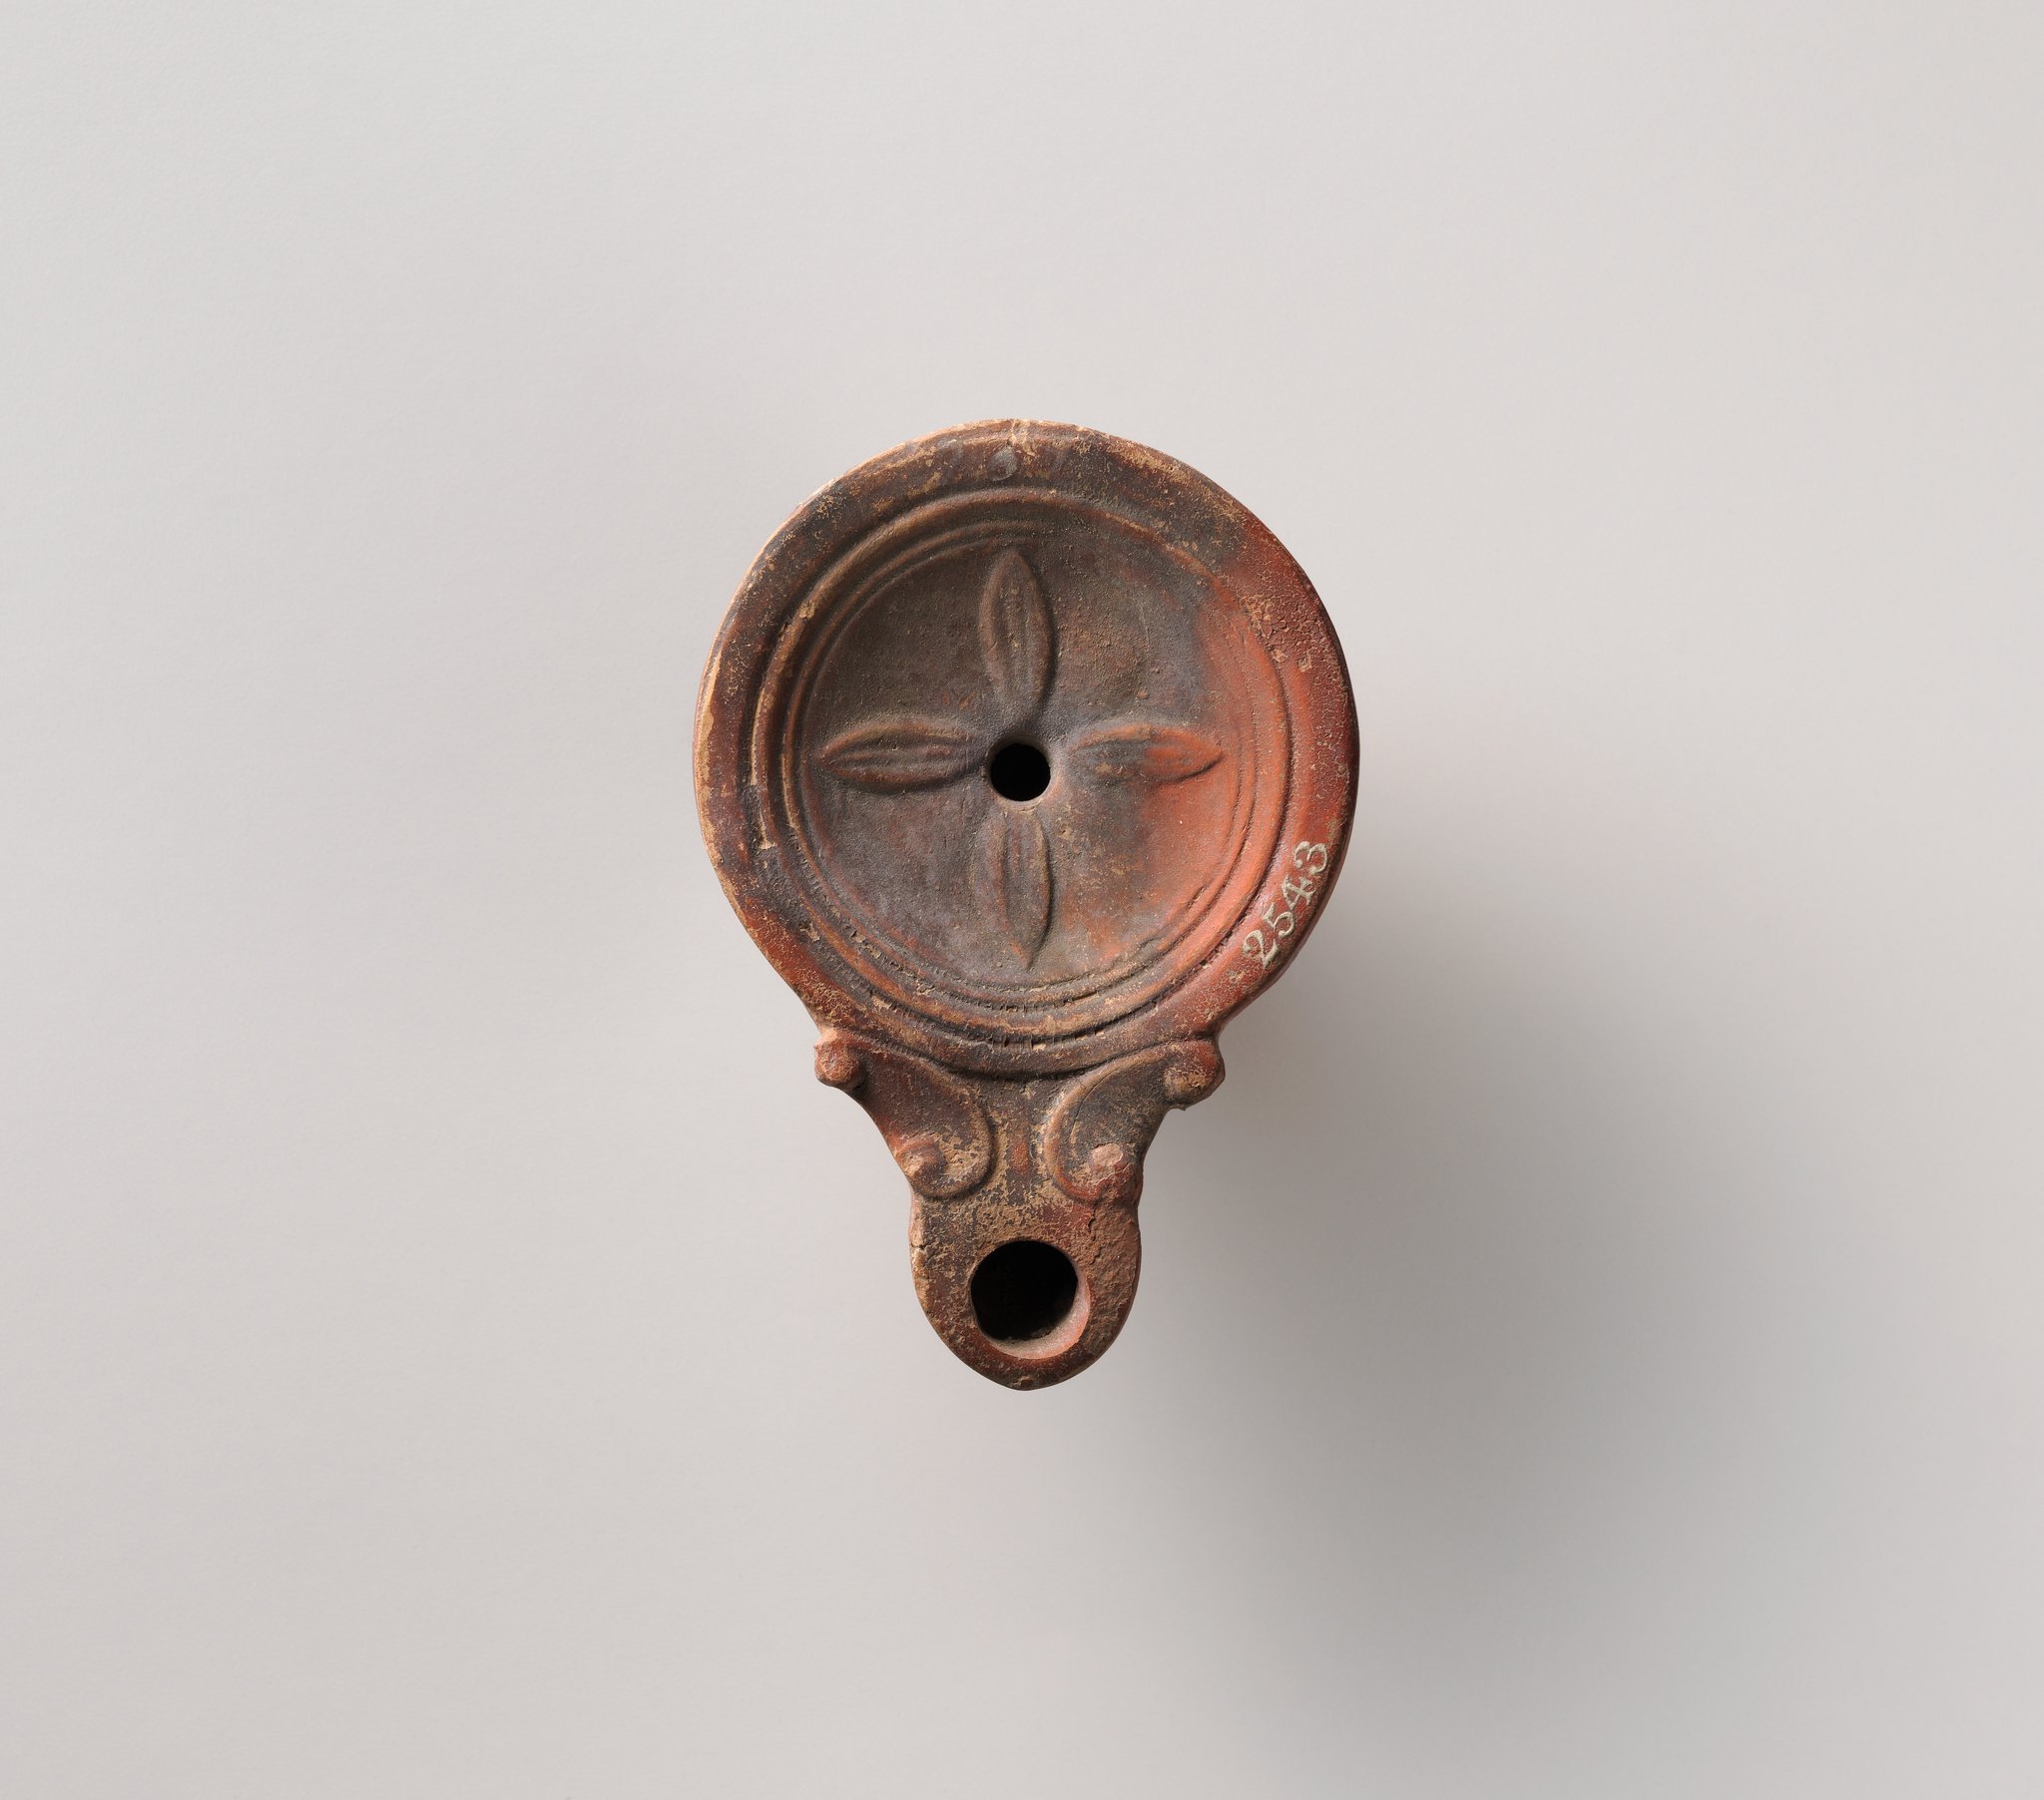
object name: lamp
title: Terracotta oil lamp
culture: roman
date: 40-100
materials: terracotta